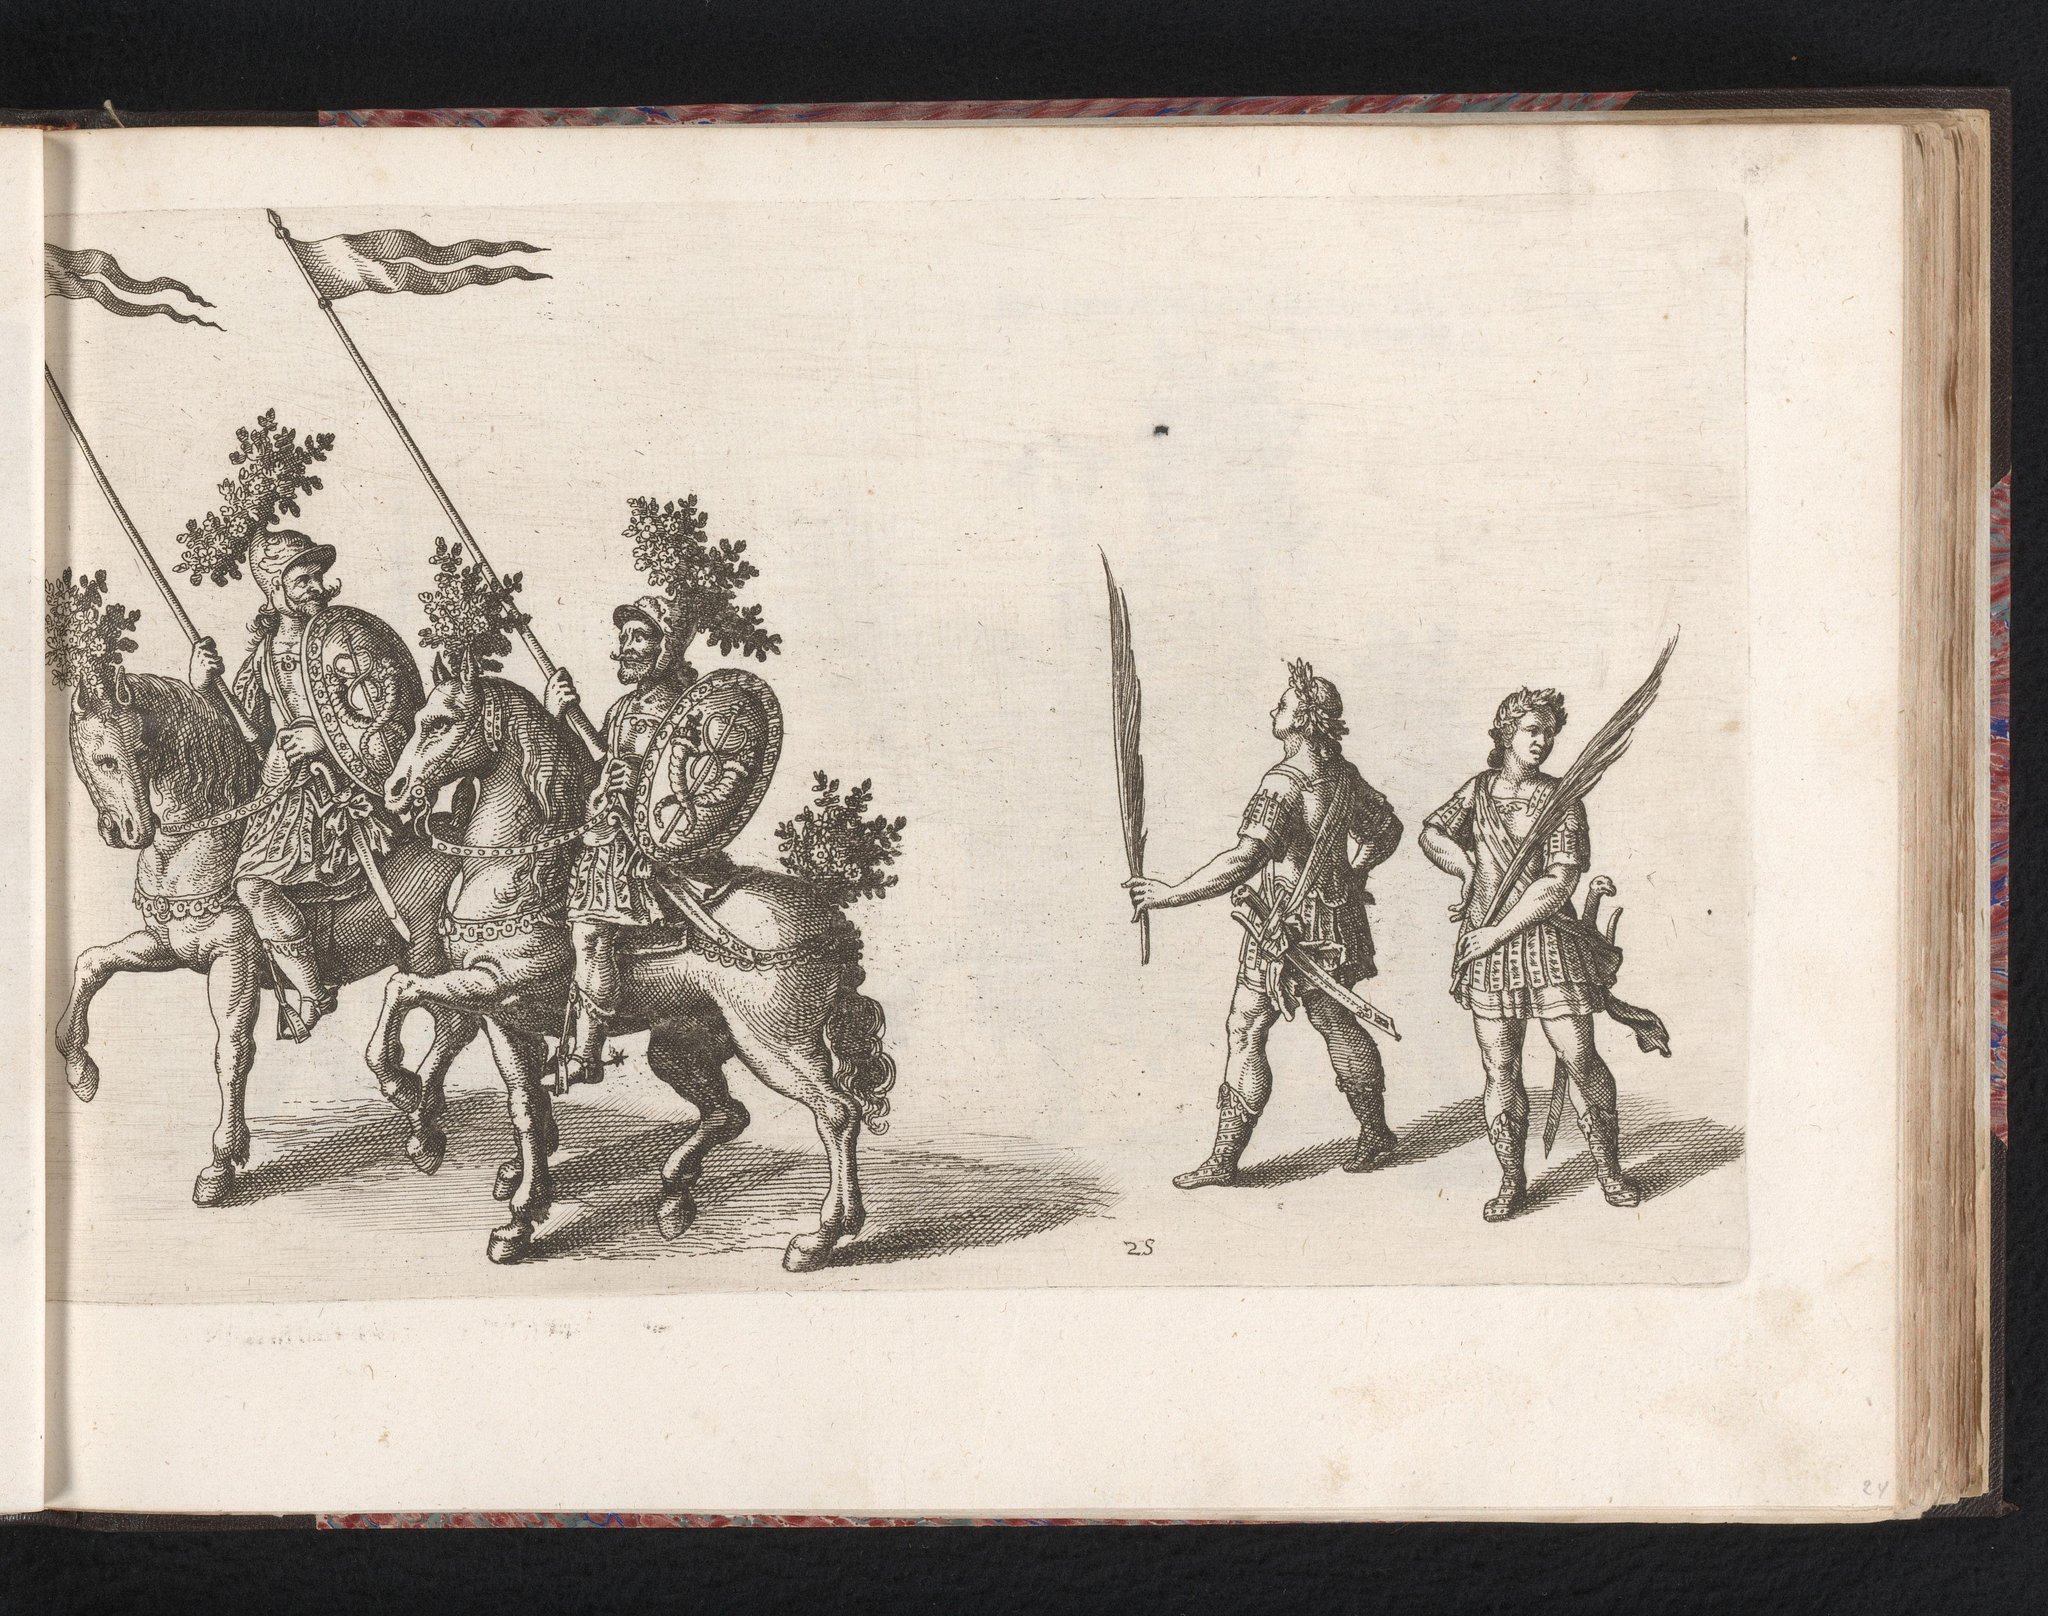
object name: album leaf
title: Optochten en ruiterspelen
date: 1618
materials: paper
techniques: etching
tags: private soldier (+ cavalry, horsemen), triumphal entry and public reception, pageant, 'entrée solennelle', 'joyeuse entrée', performance in the open air (pleasure fair), herald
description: Genummerd: 24. Deze prent maakt deel uit van een album.